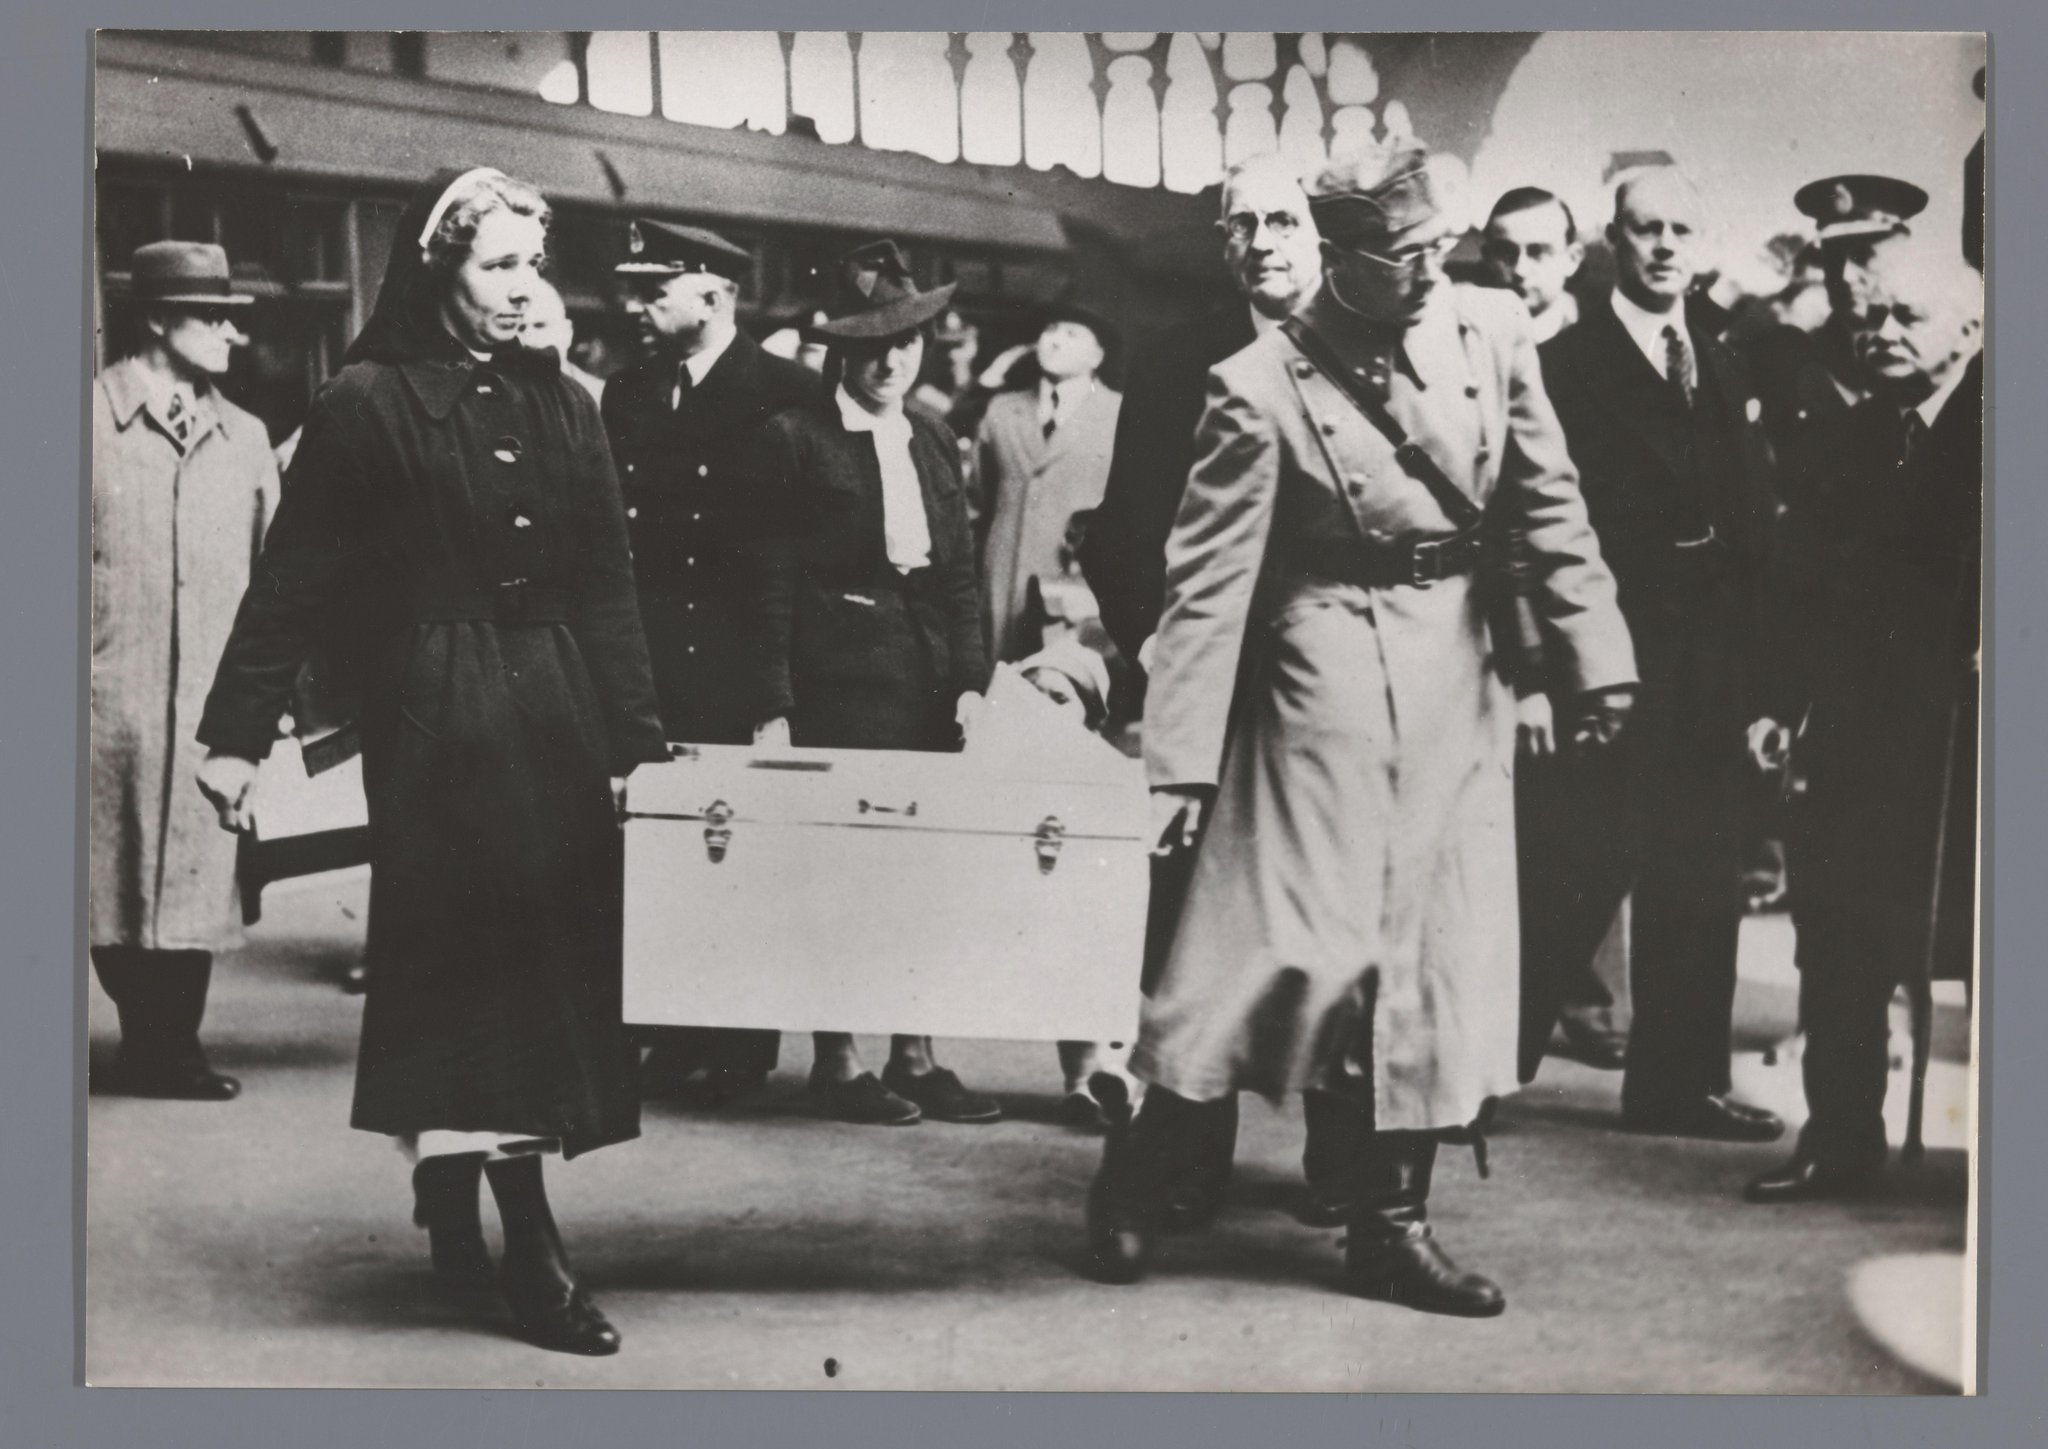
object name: photograph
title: Londen met reiswieg met Prinses Irene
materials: paper, photographic support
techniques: gelatin silver print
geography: amsterdam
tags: london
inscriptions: stamp: ‘copyright ANEFO Achtergracht 17 Amsterdam C’